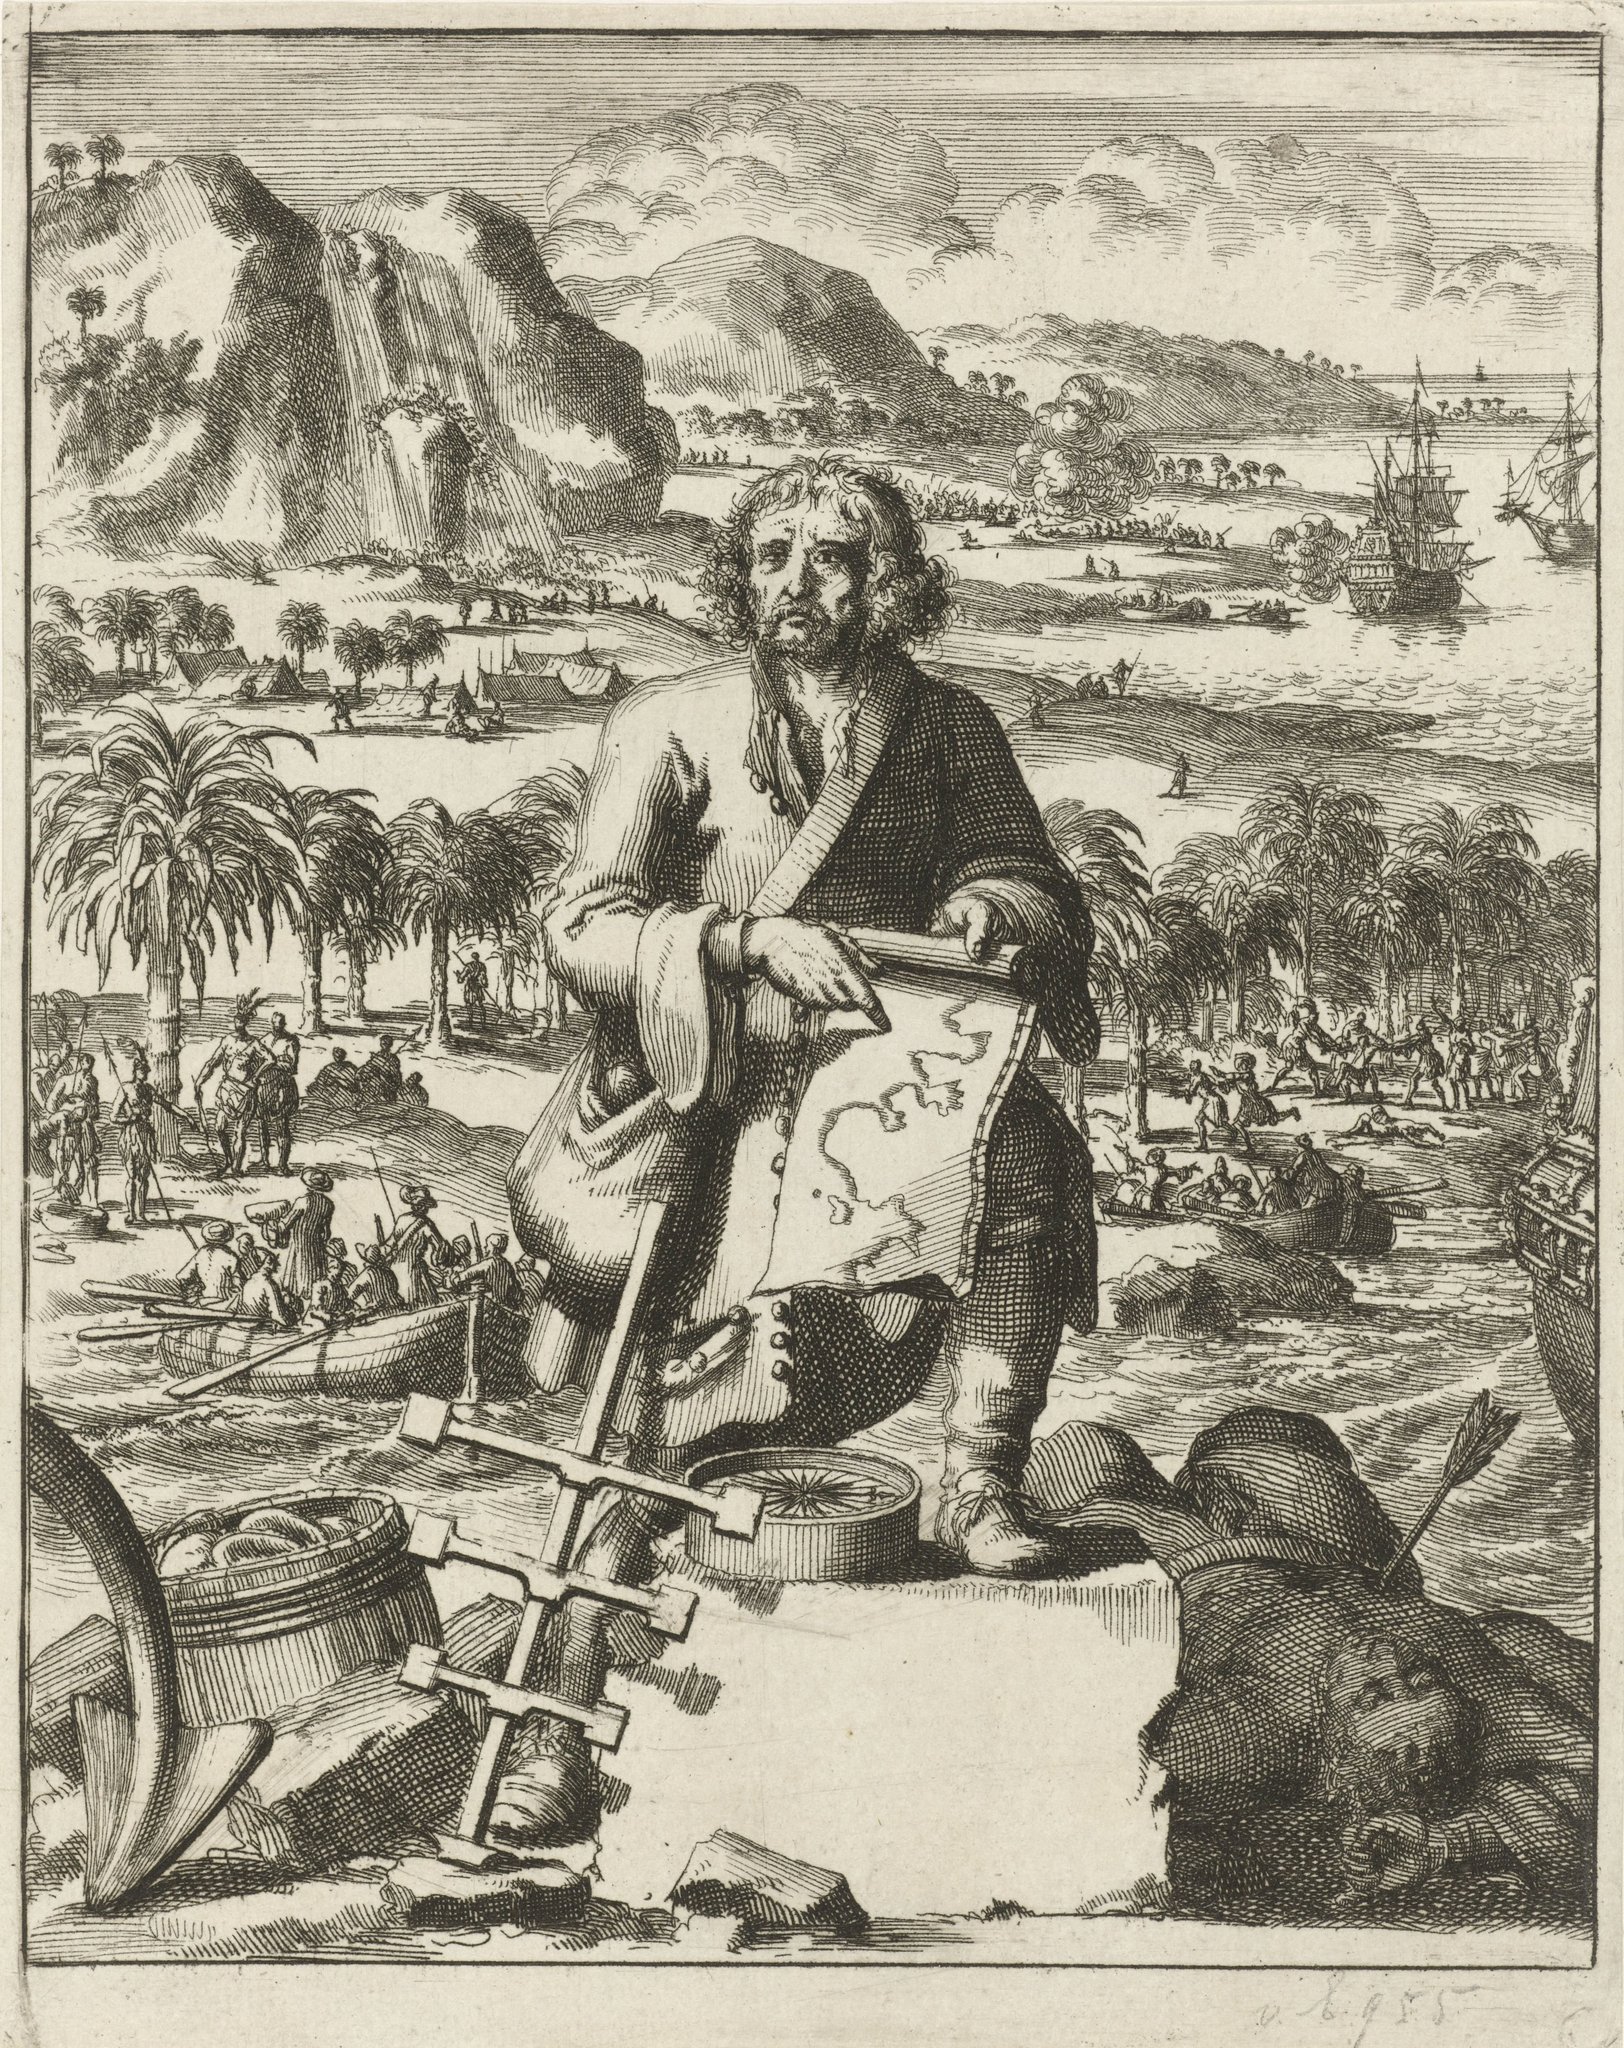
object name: print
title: Man wijzend op een landkaart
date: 1688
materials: paper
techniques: etching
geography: amsterdam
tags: (map of) north america, indigenous peoples of north america, exploration, expedition, voyage of discovery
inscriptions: collector's mark: Lugt 2228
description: Man wijzend op een landkaart, op de achtergrond de kust van Noord-Amerika (Louisiana) waar Franse ontdekkingsreizigers voet aan wal zetten. Op de achtergrond vinden gevechten plaats met de lokale bevolking, waarschijnllijk de Chickasaw.